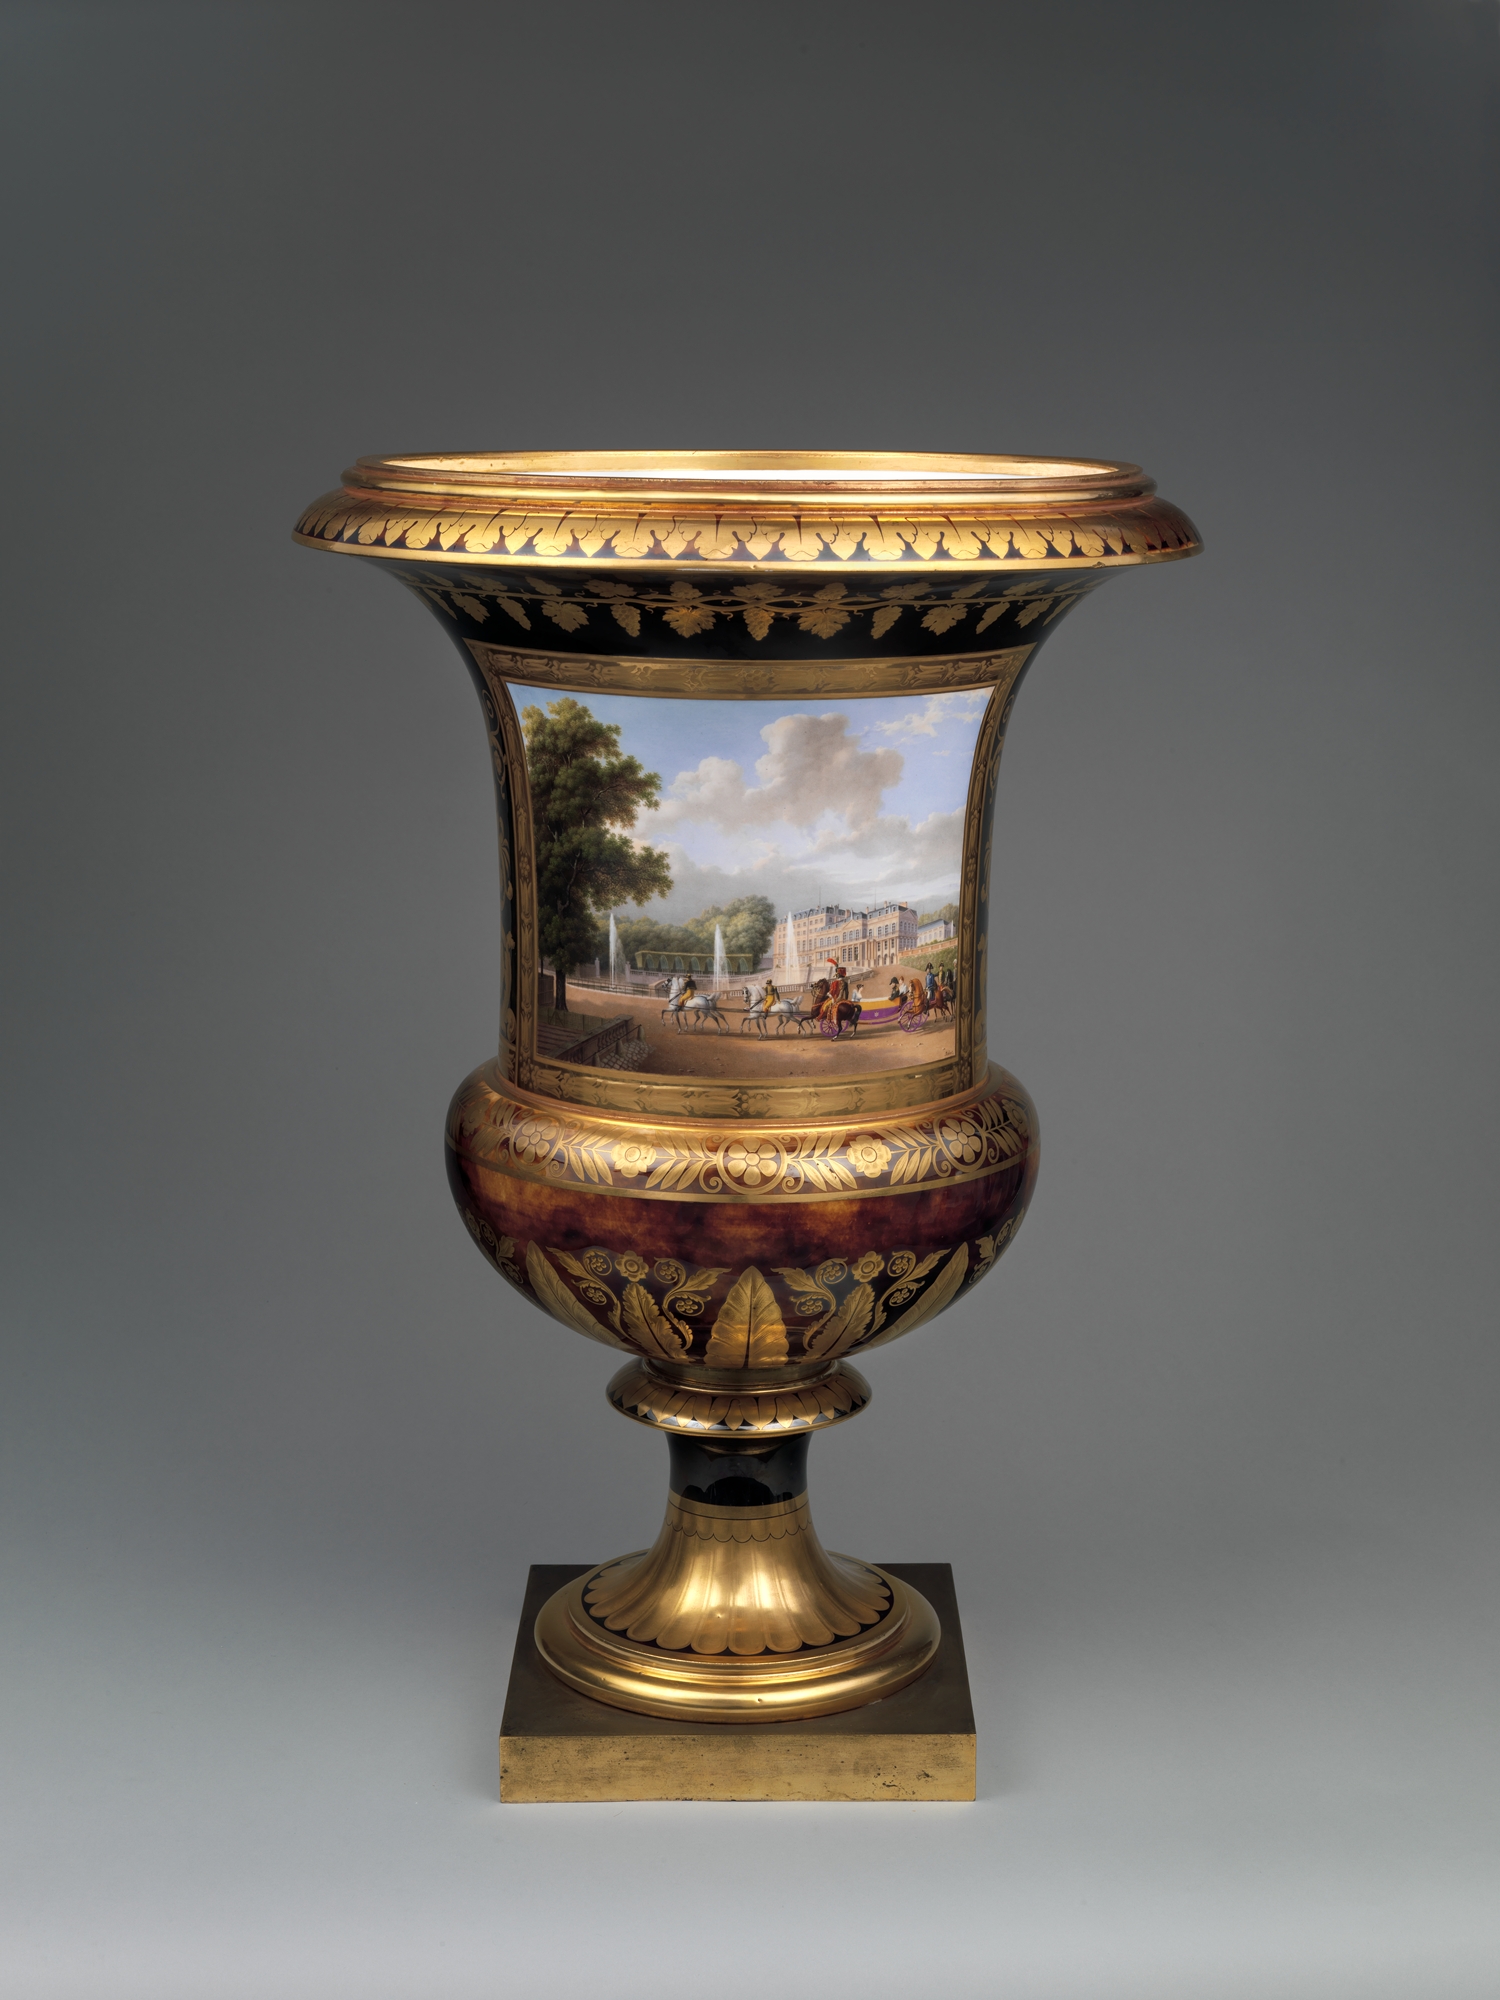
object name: vase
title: Medici vase with a scene of the château at Saint-Cloud (one of a pair)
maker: sèvres manufactory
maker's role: manufactory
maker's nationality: french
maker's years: 1740-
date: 1811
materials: enamel, gilt bronze, gold, hard paste porcelain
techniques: polychrome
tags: houses,gardens,napoleon i,horses,carriages